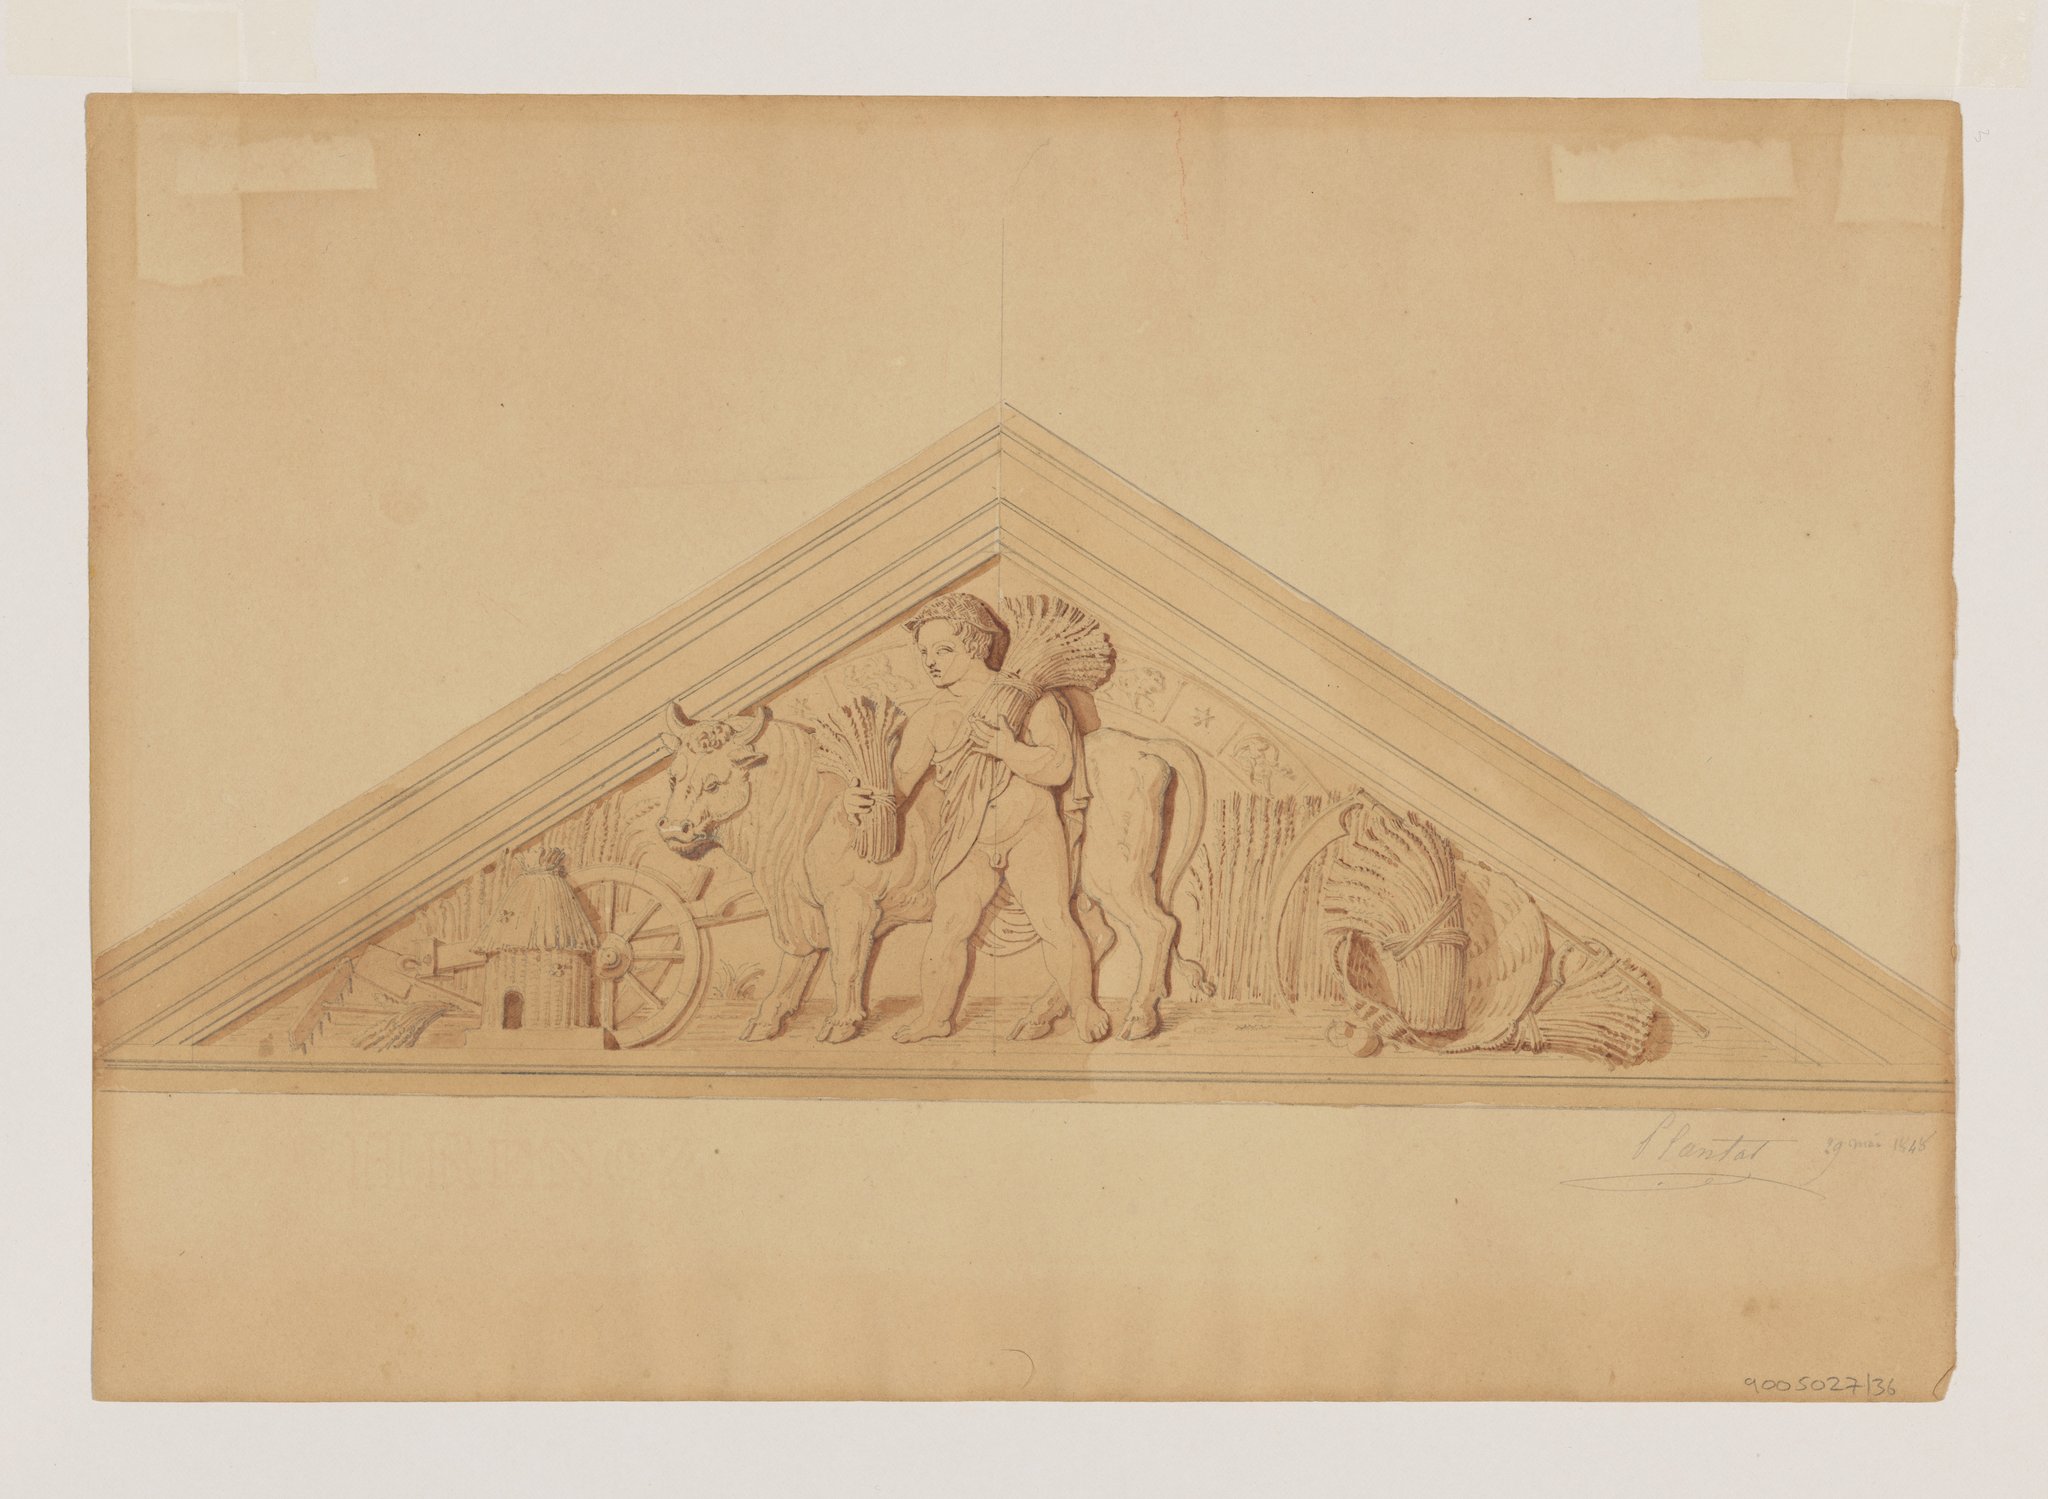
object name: drawing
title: Design for a Pediment with a Putto and Bull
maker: jean-baptiste louis plantar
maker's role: artist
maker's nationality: french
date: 1834-1866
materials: graphite, ink, watercolor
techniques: pen